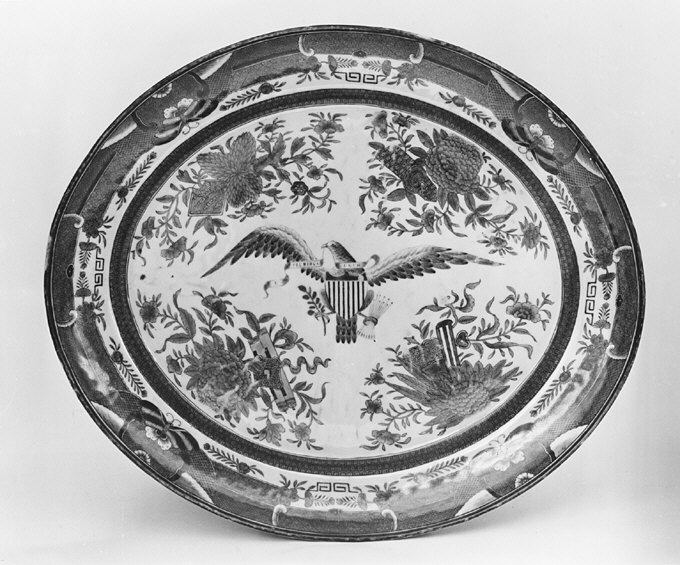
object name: platter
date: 1767-1833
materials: hard paste porcelain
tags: birds,flowers,coat of arms